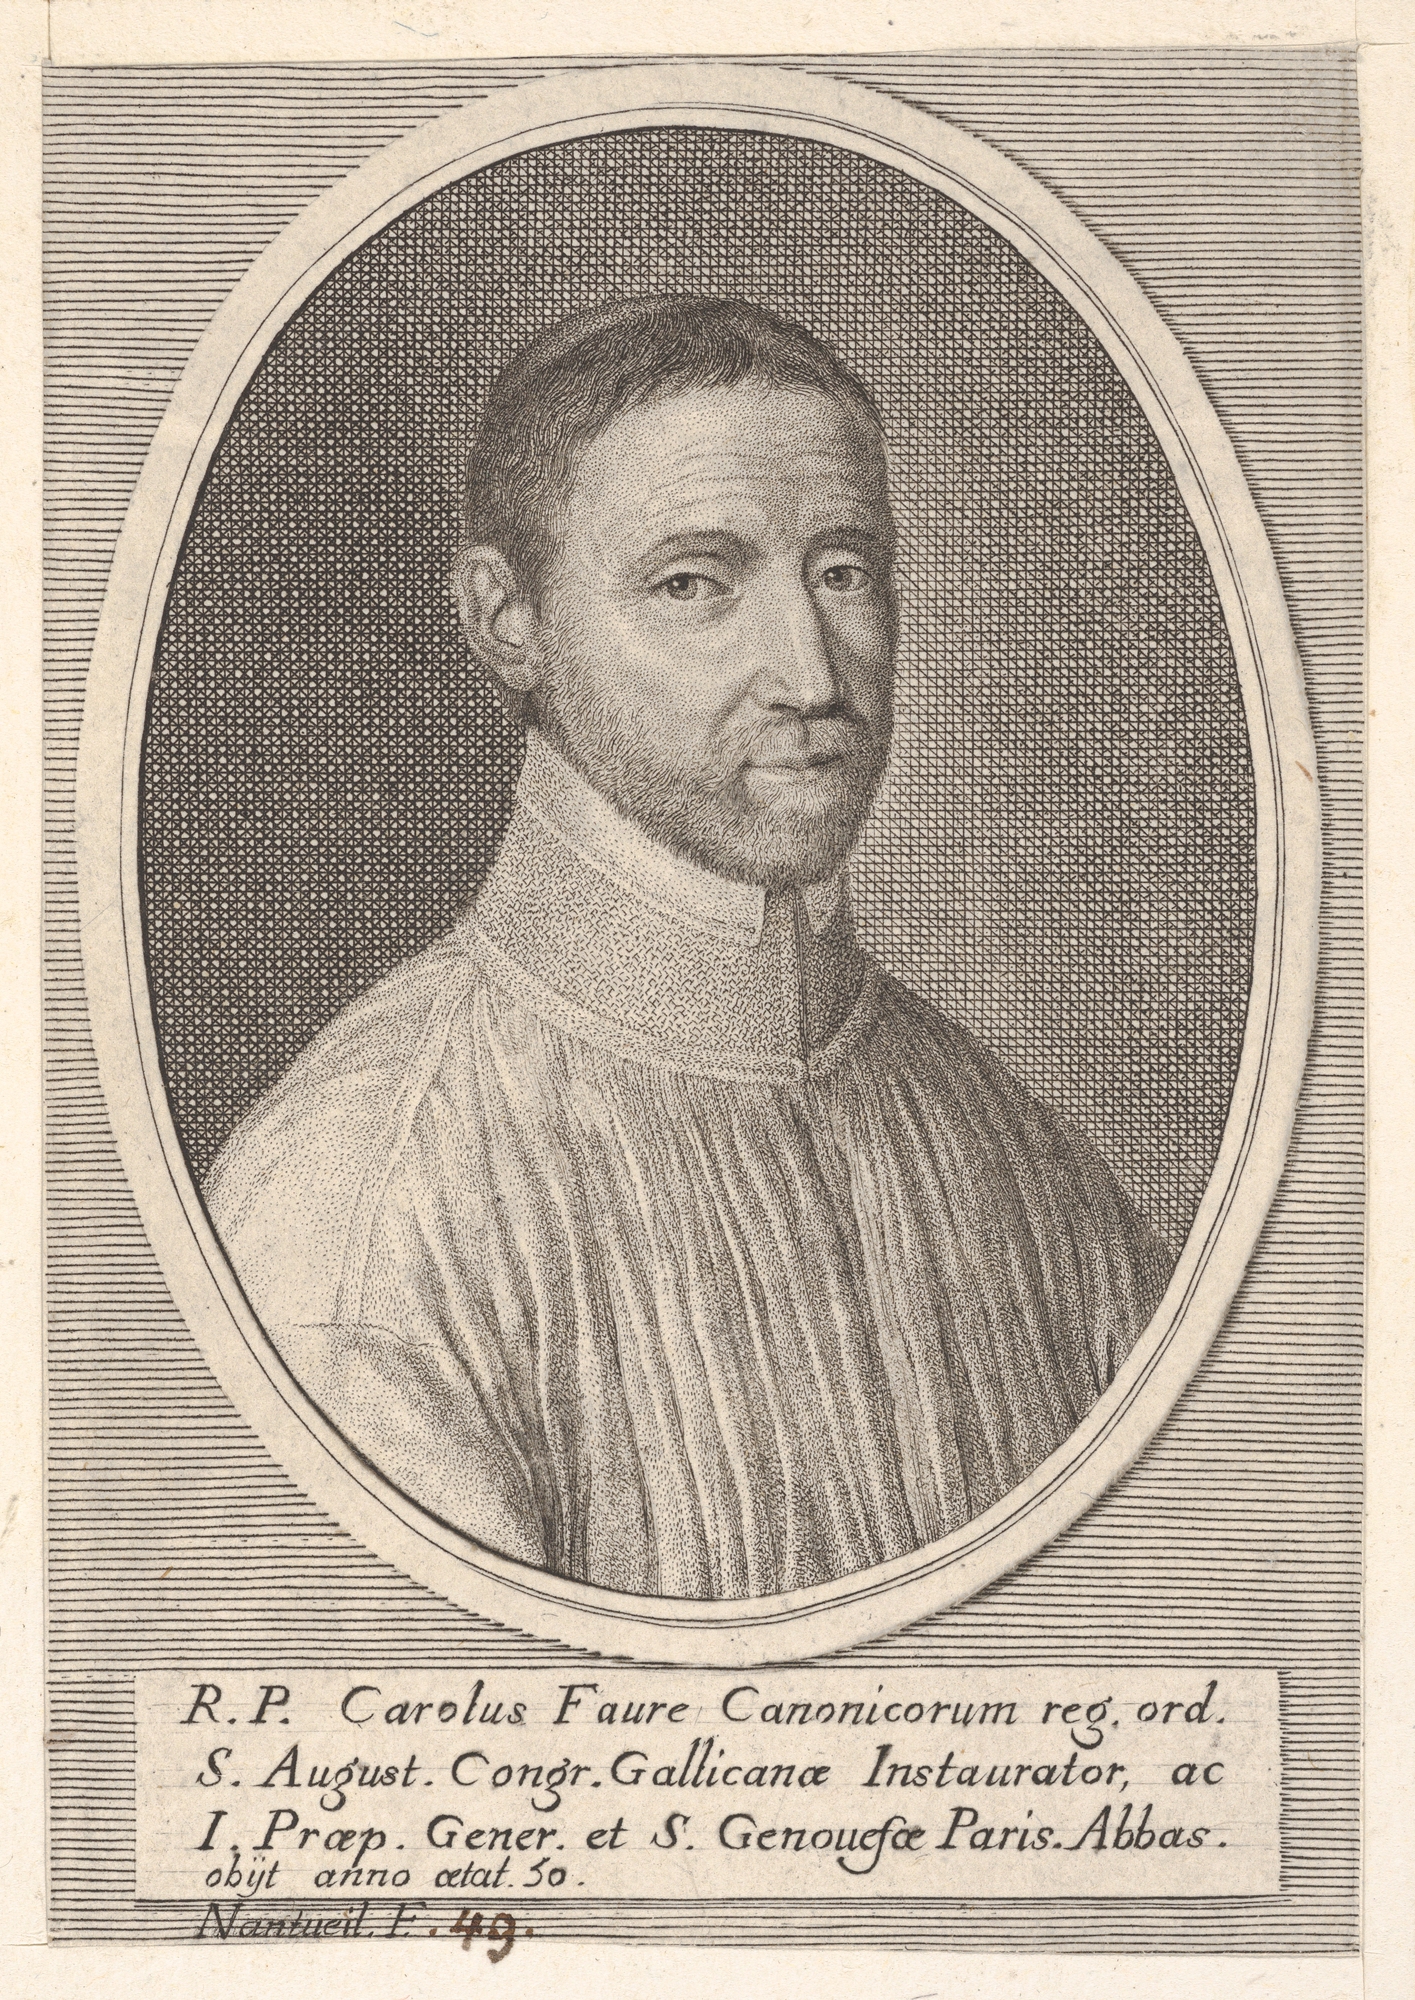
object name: print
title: Charles Faure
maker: robert nanteuil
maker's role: artist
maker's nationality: french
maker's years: 1623-1678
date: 1648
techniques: engraving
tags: men,portraits